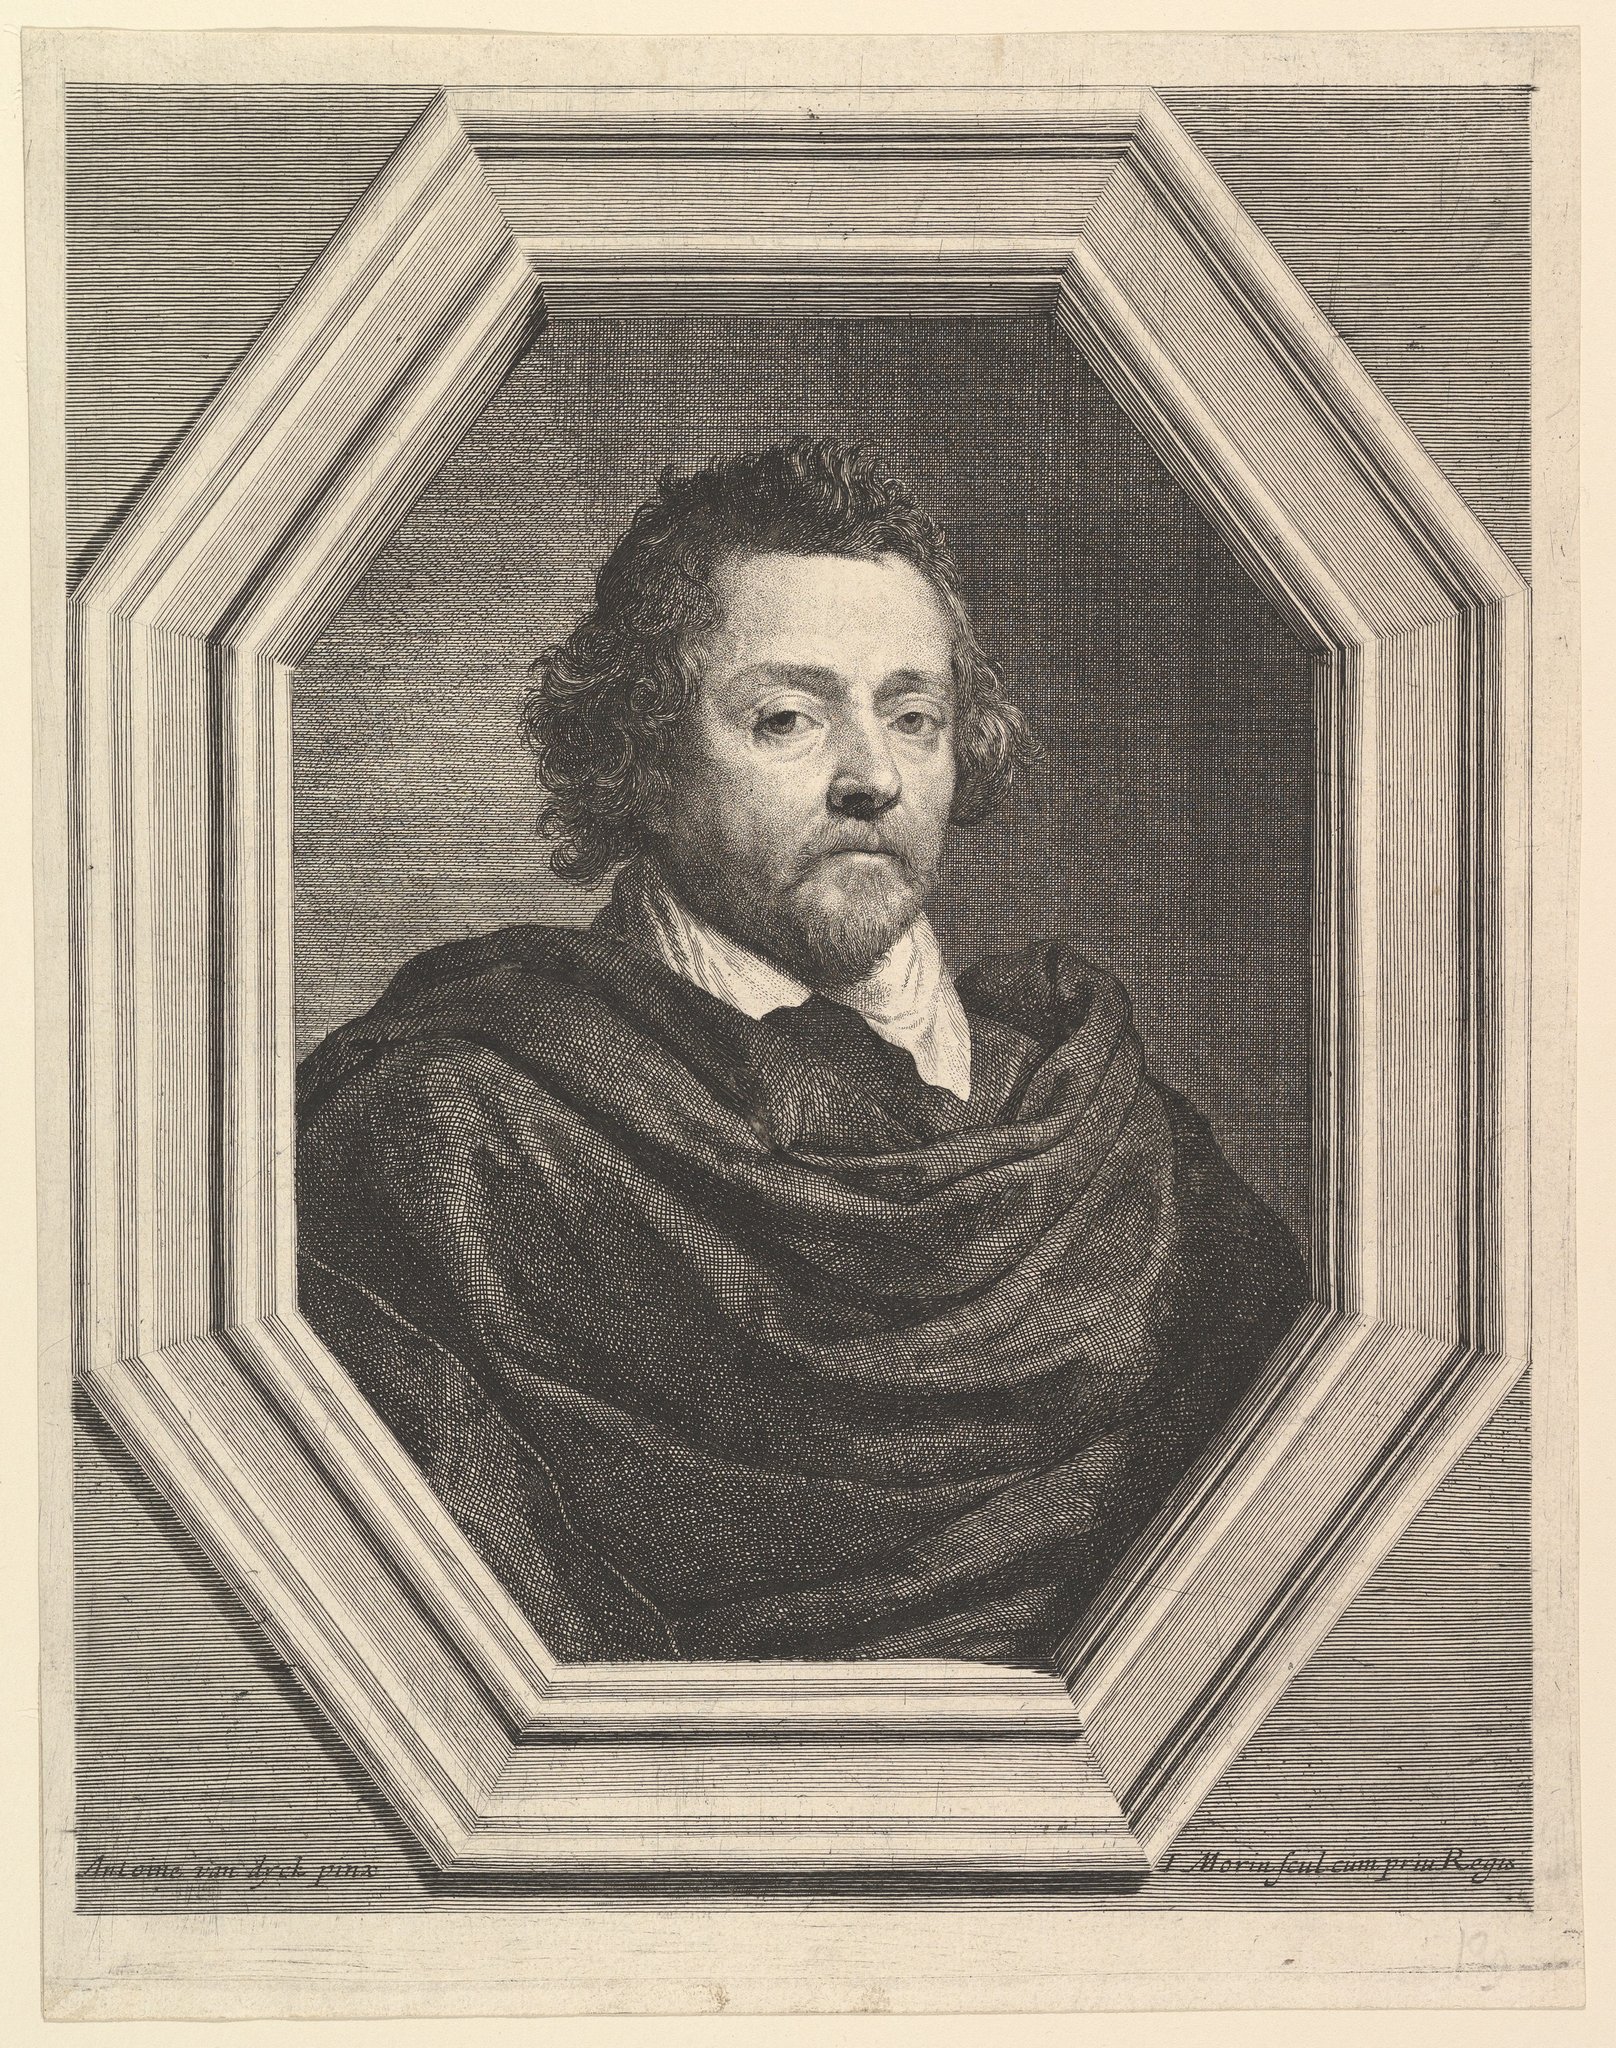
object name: print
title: Nicolas Chrystin, bourgeois d'Anvers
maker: jean morin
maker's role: artist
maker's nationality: french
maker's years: 1605-1650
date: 1605-1650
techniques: etching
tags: men,portraits